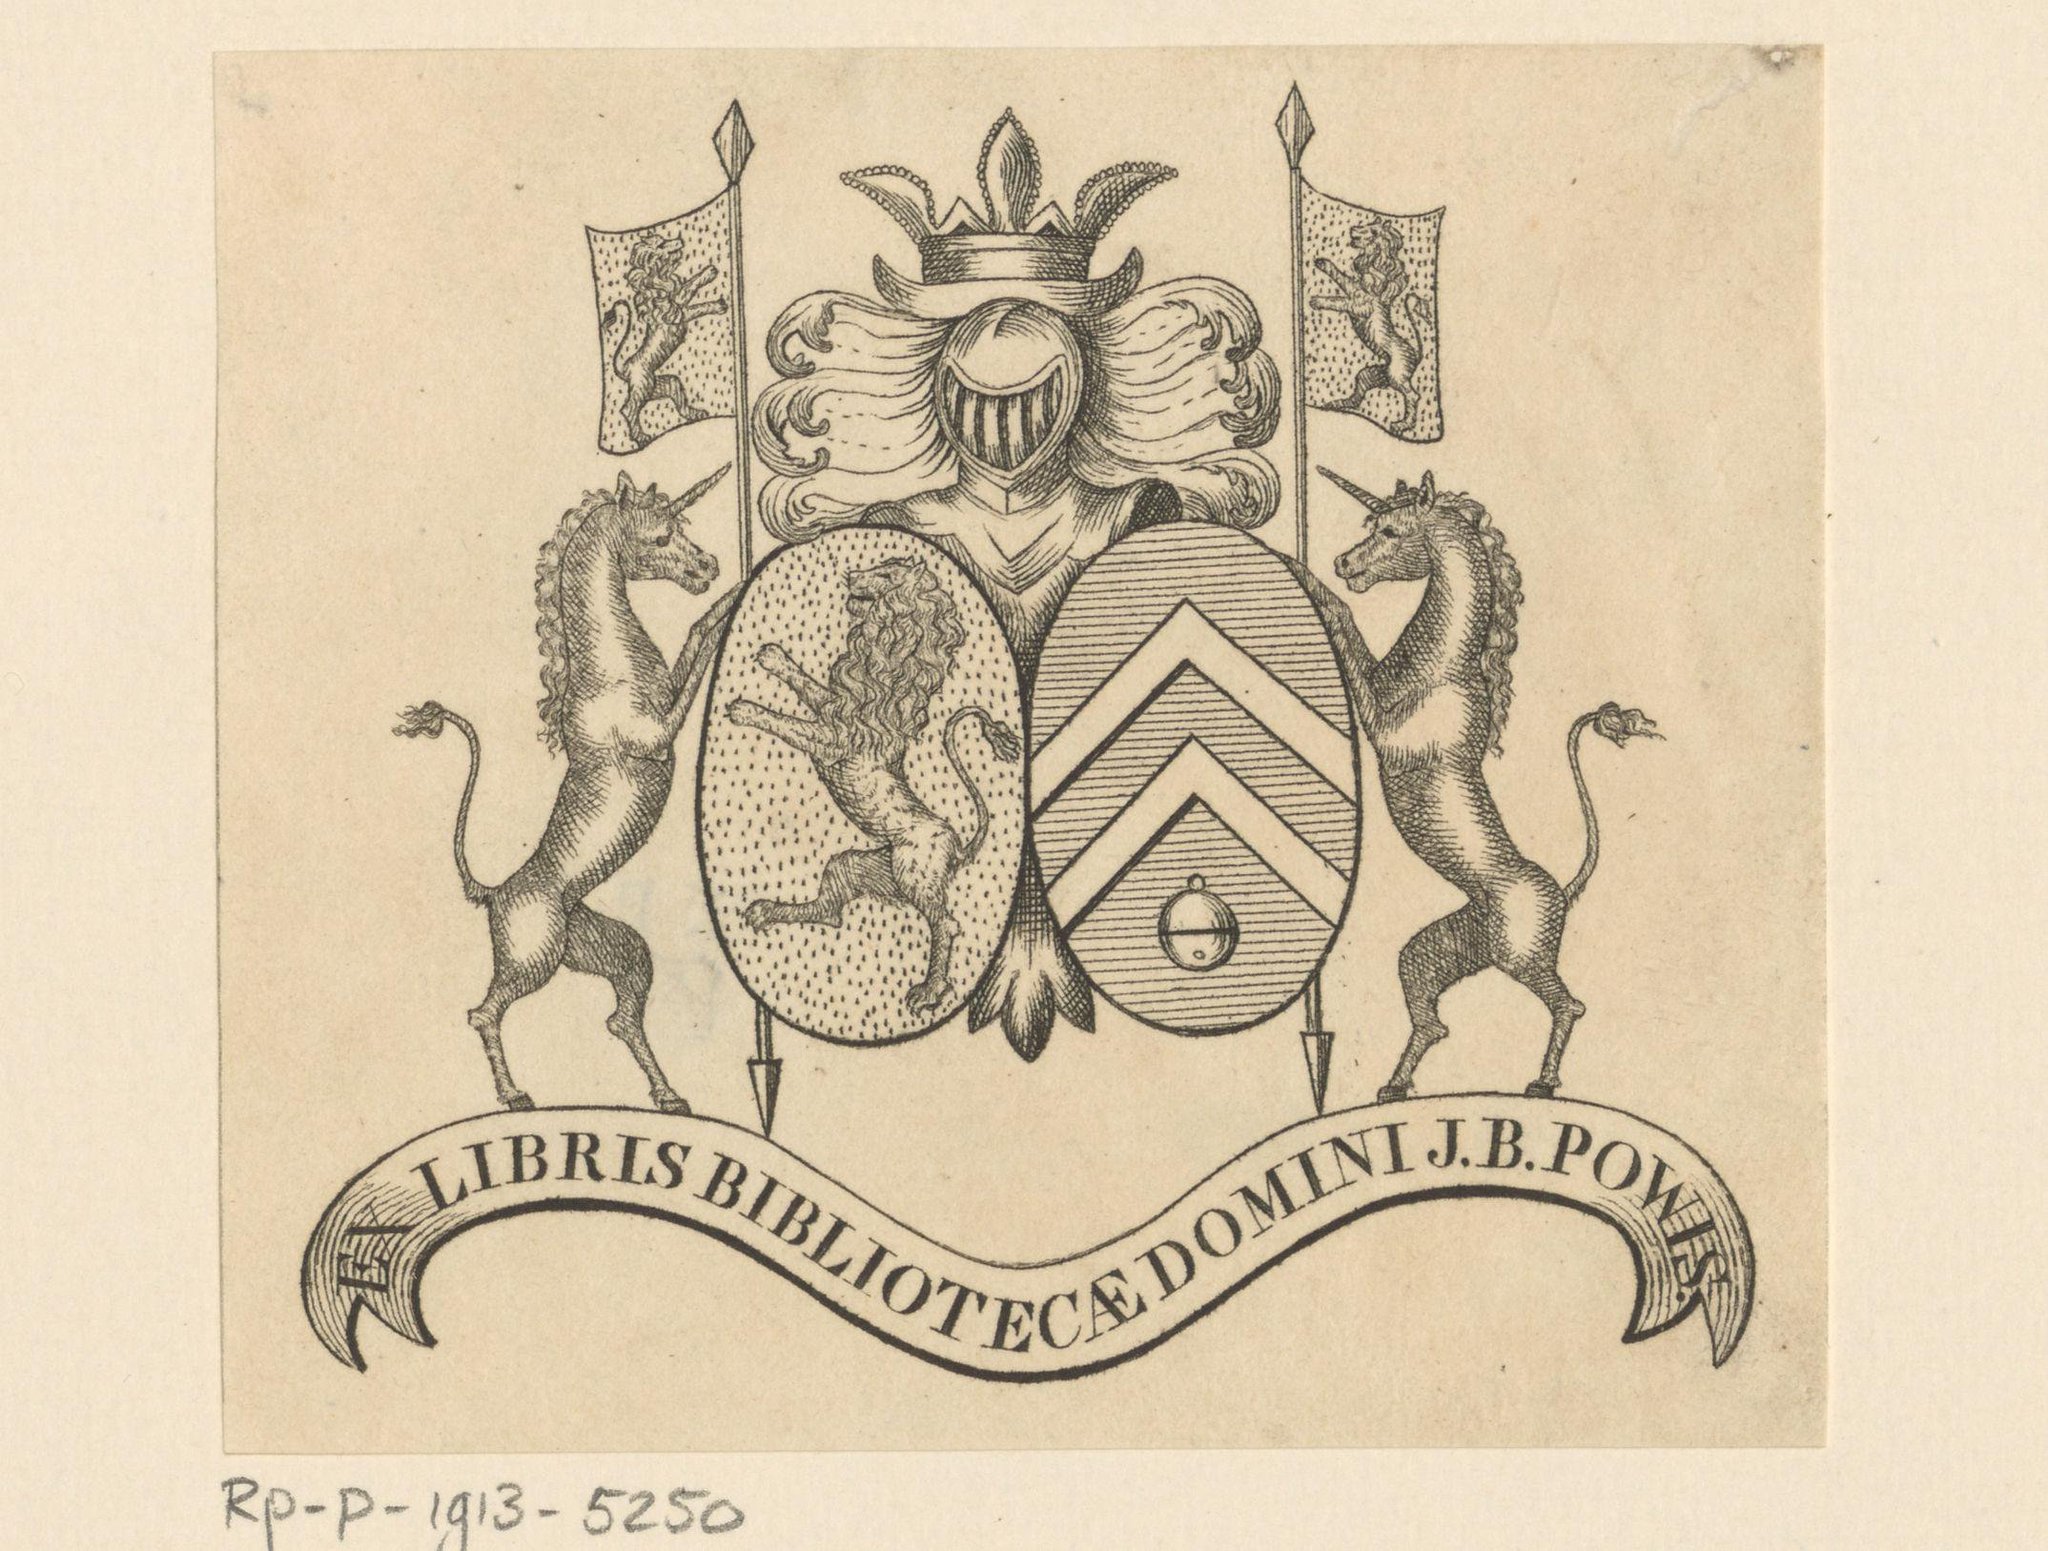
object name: bookplate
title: Ex libris van Bibliothecae Domini J.B. Powis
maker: Anonymous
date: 1700-1799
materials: paper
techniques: engraving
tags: armorial bearing, heraldry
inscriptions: collector's mark: Lugt 2233, collector's mark: Lugt 2760